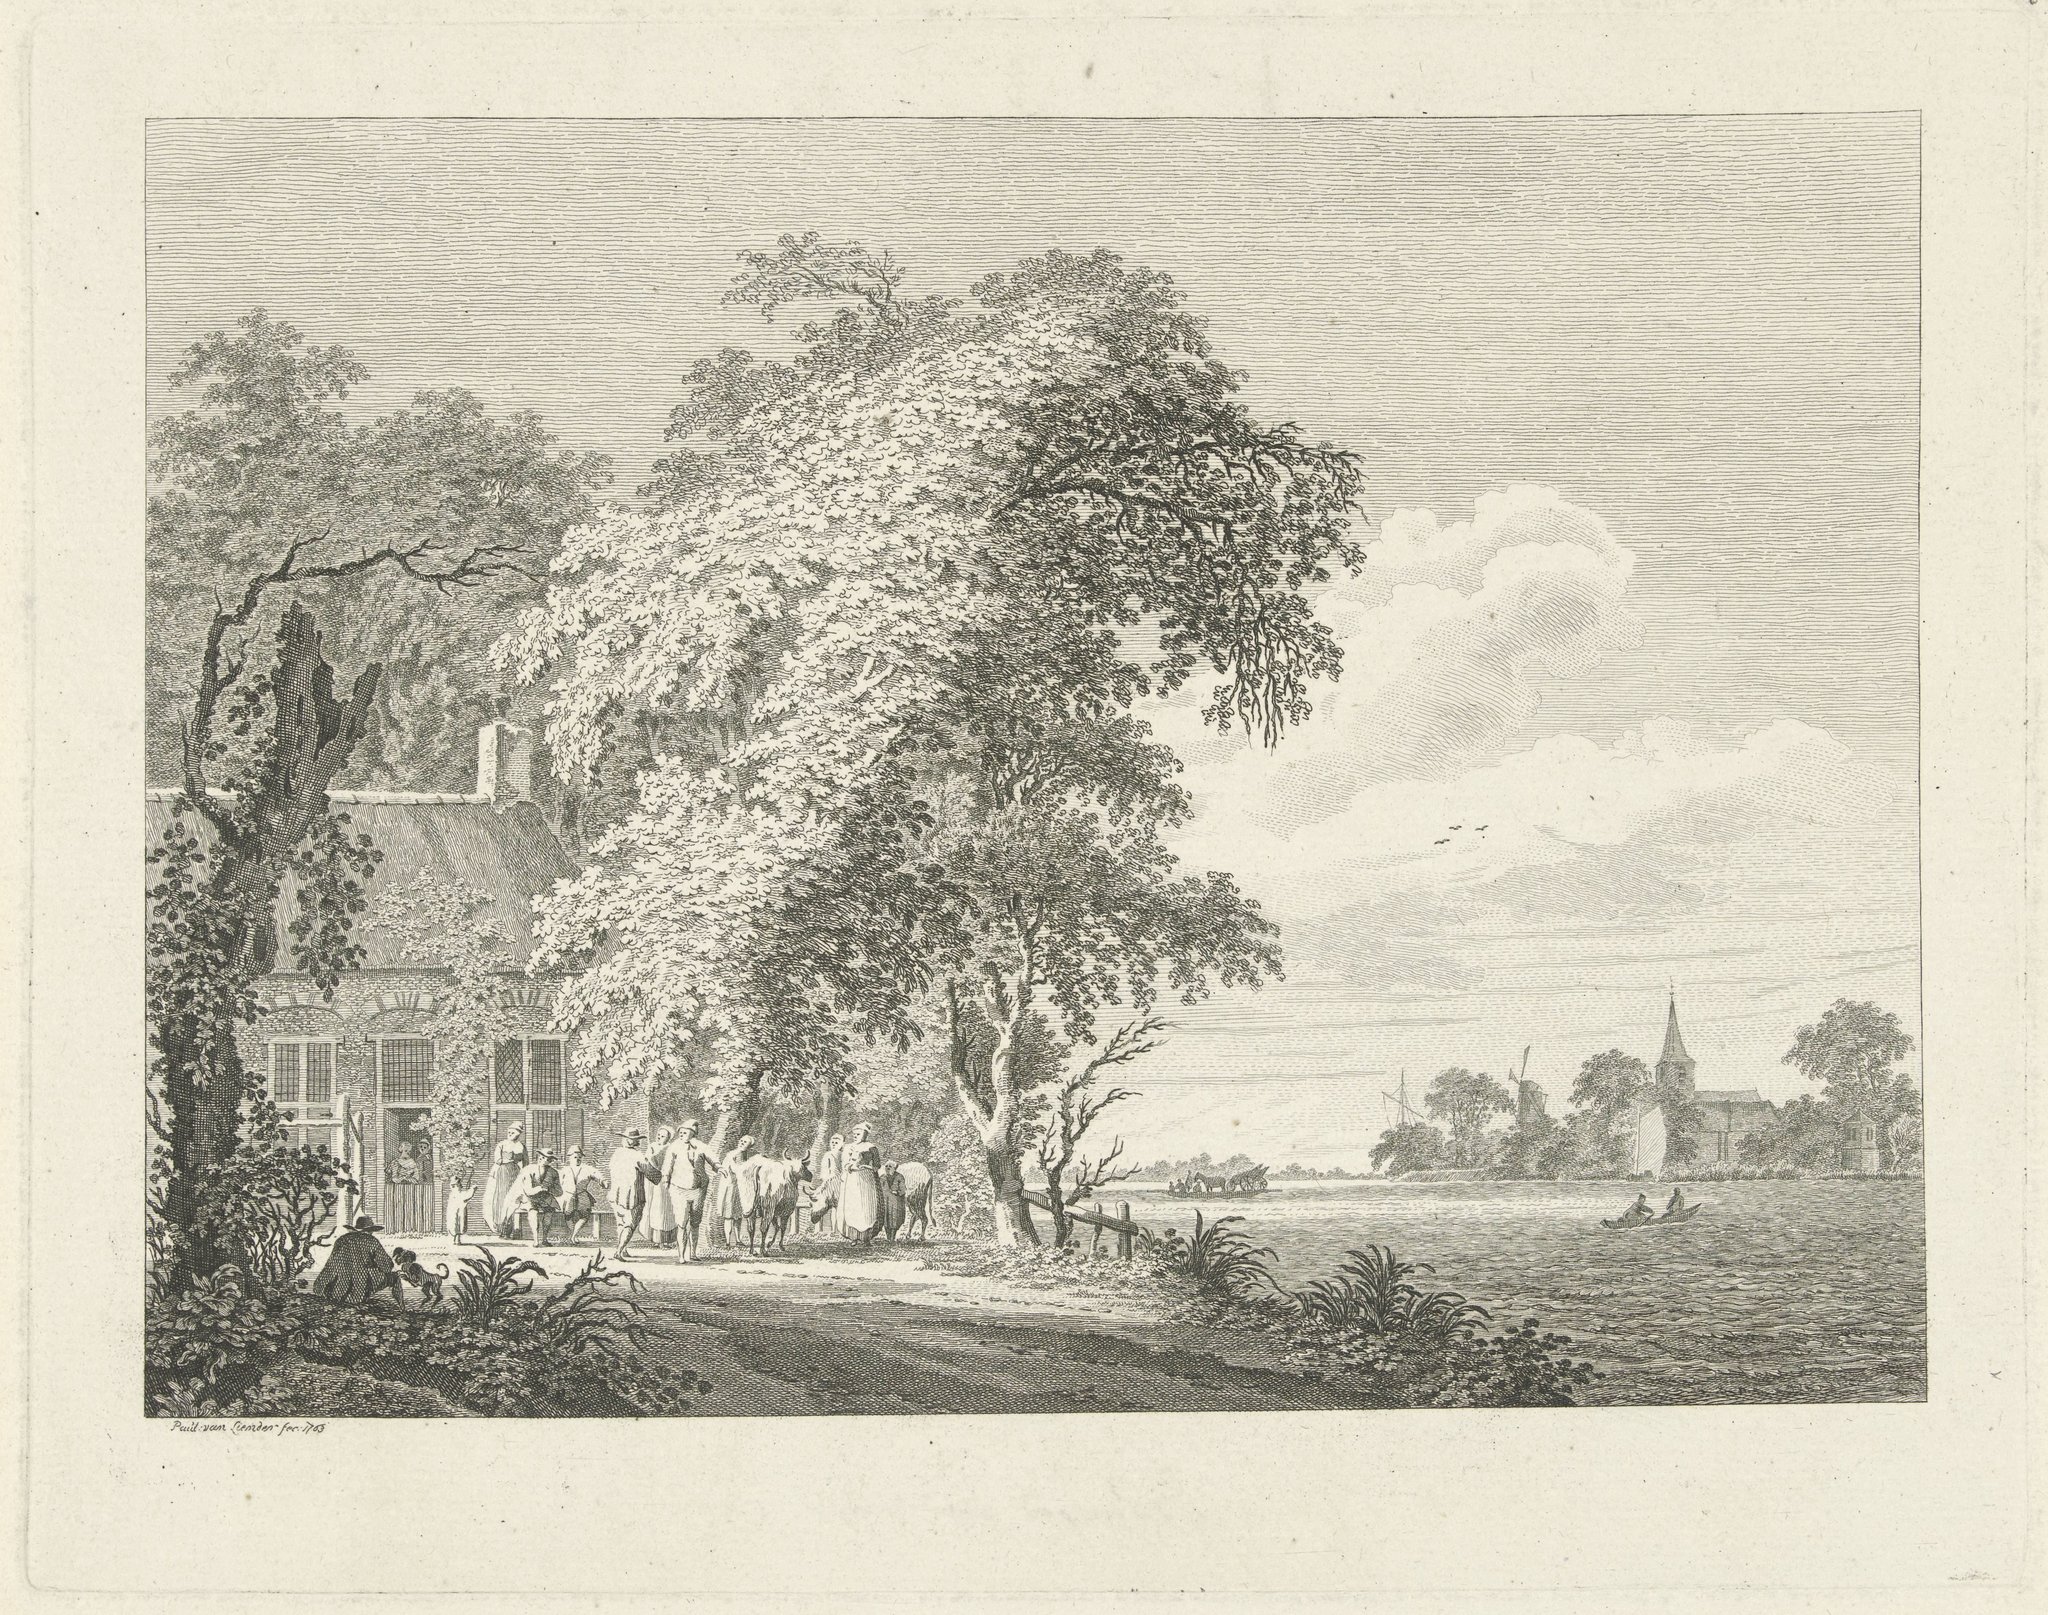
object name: print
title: Gezicht op het veerhuis in Krimpen aan de Lek, 1756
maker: paulus van liender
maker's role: draughtsman, print maker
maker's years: 1731-1797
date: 1763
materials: paper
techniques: etching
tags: landscapes with waters, waterscapes, seascapes (in the temperate zone), village, ferry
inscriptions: collector's mark: Lugt 2228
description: Gezicht op het veerhuis in het dorp Krimpen aan de Lek met figuren en dieren op het erf. Op de Lek varen een veerboot en roeiboot, aan de overzijde ligt de dorpskern.